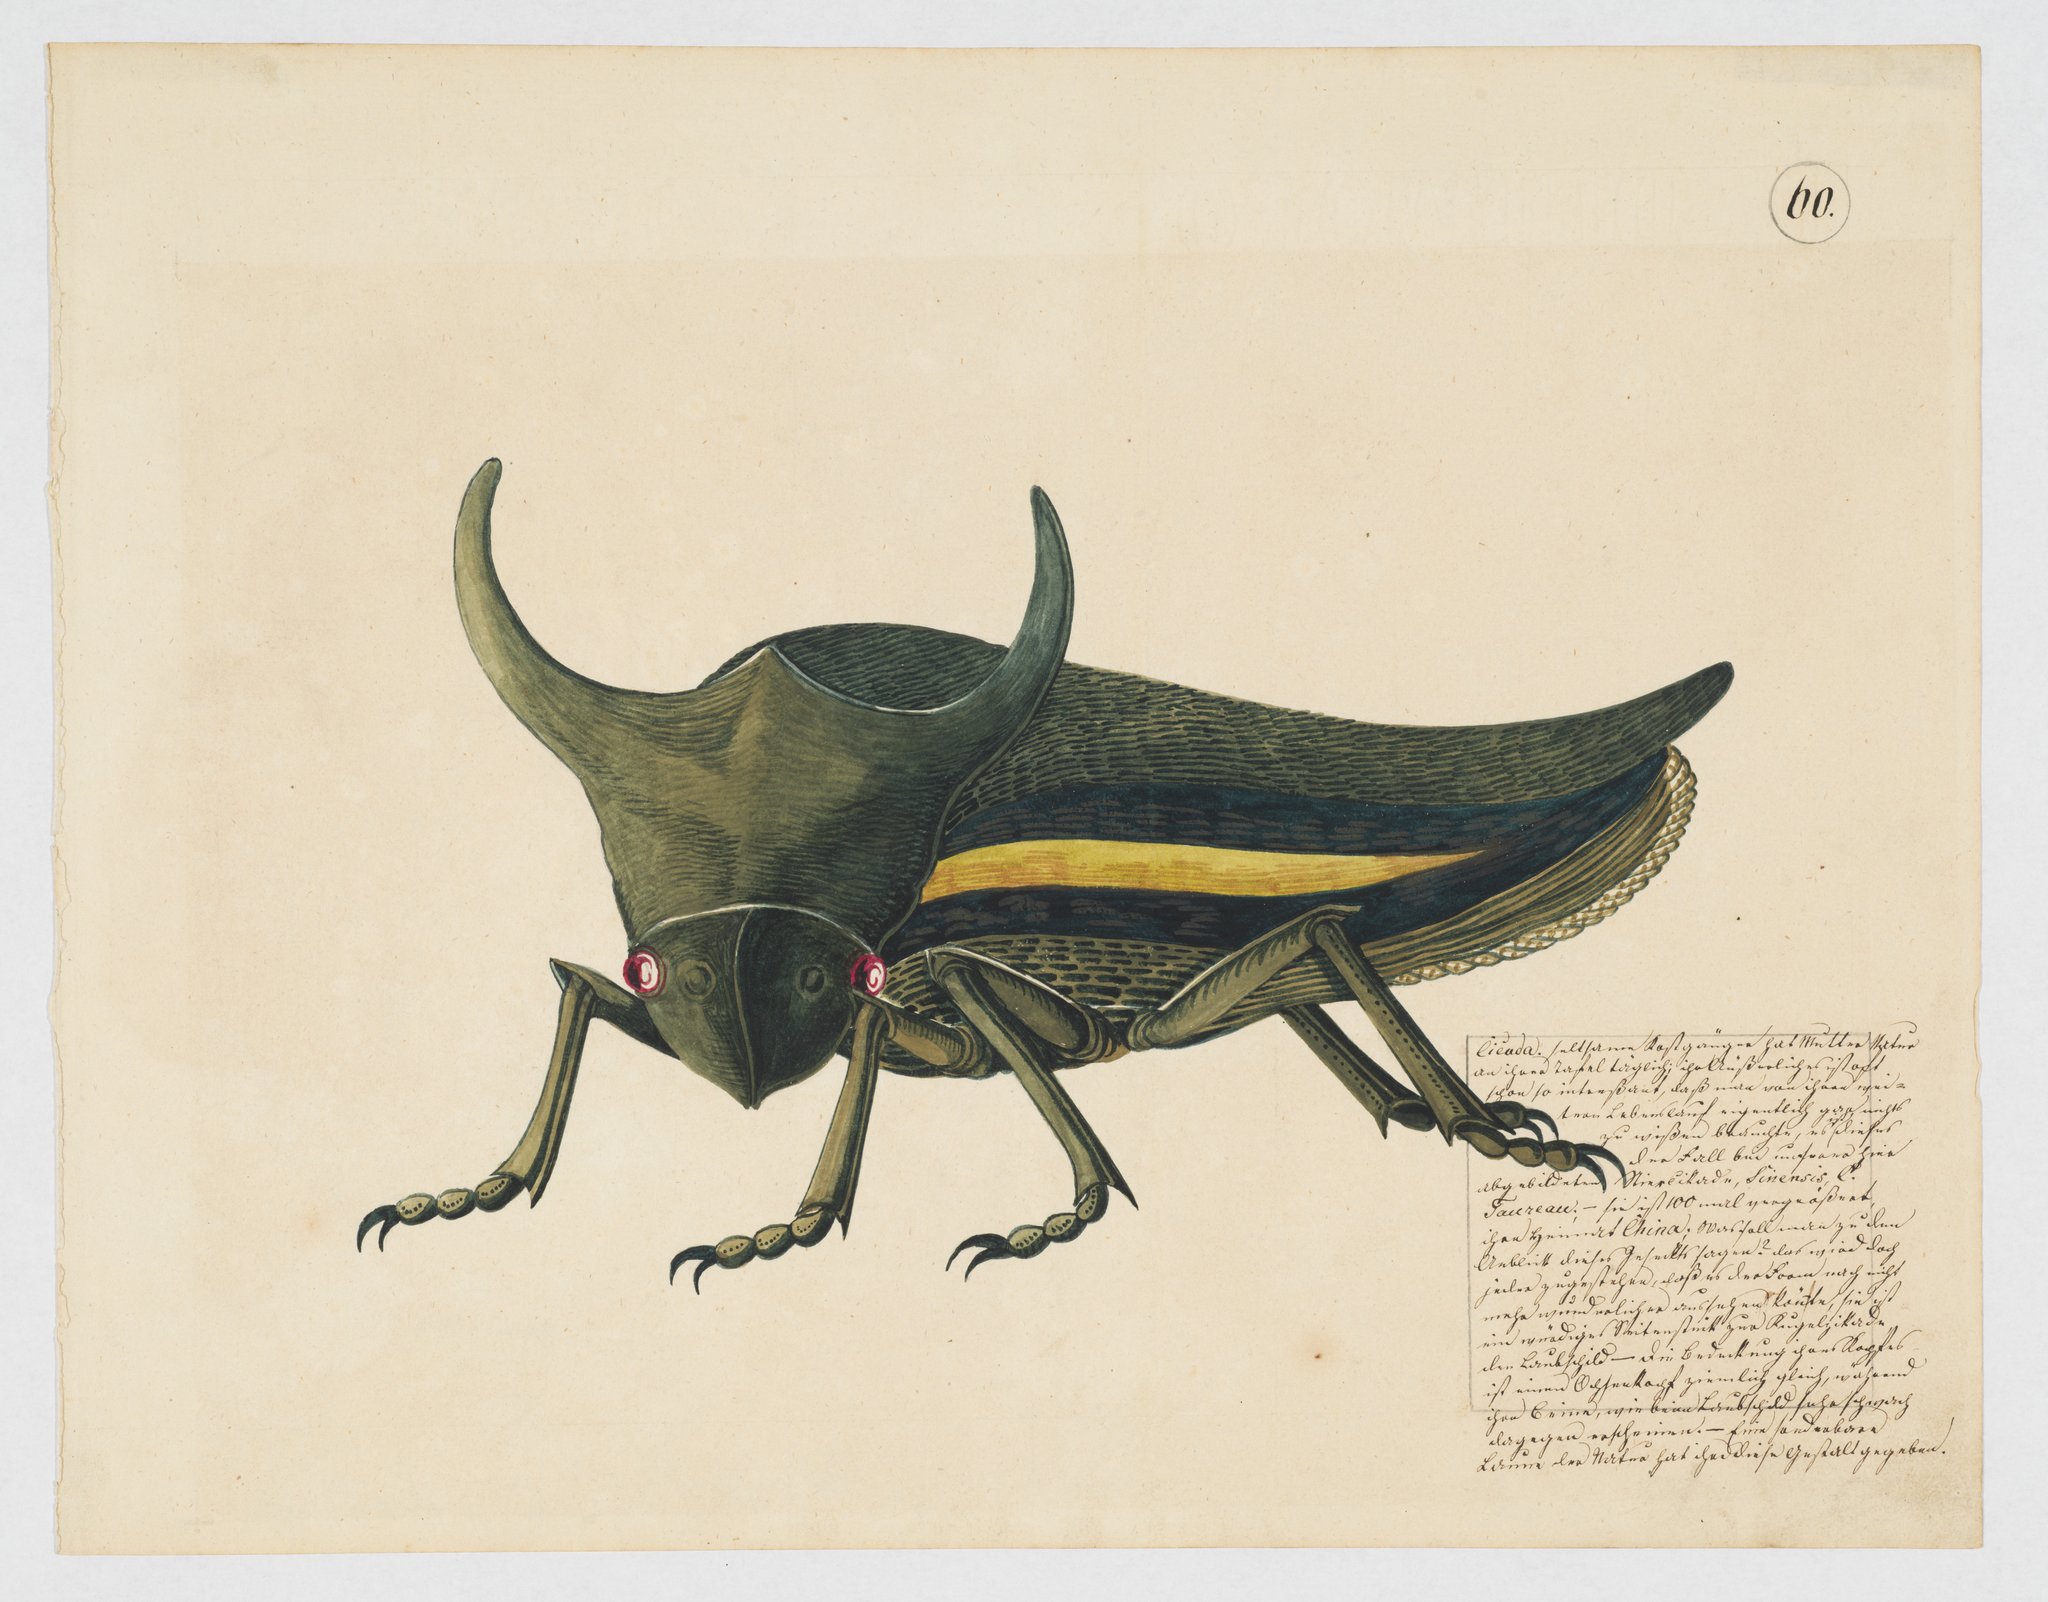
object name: drawing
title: Fanciful depiction of a cicada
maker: anonymous, german, 19th century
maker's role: artist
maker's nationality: german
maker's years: 1800-1899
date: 1862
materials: graphite, ink, paper, watercolor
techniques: pen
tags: insects